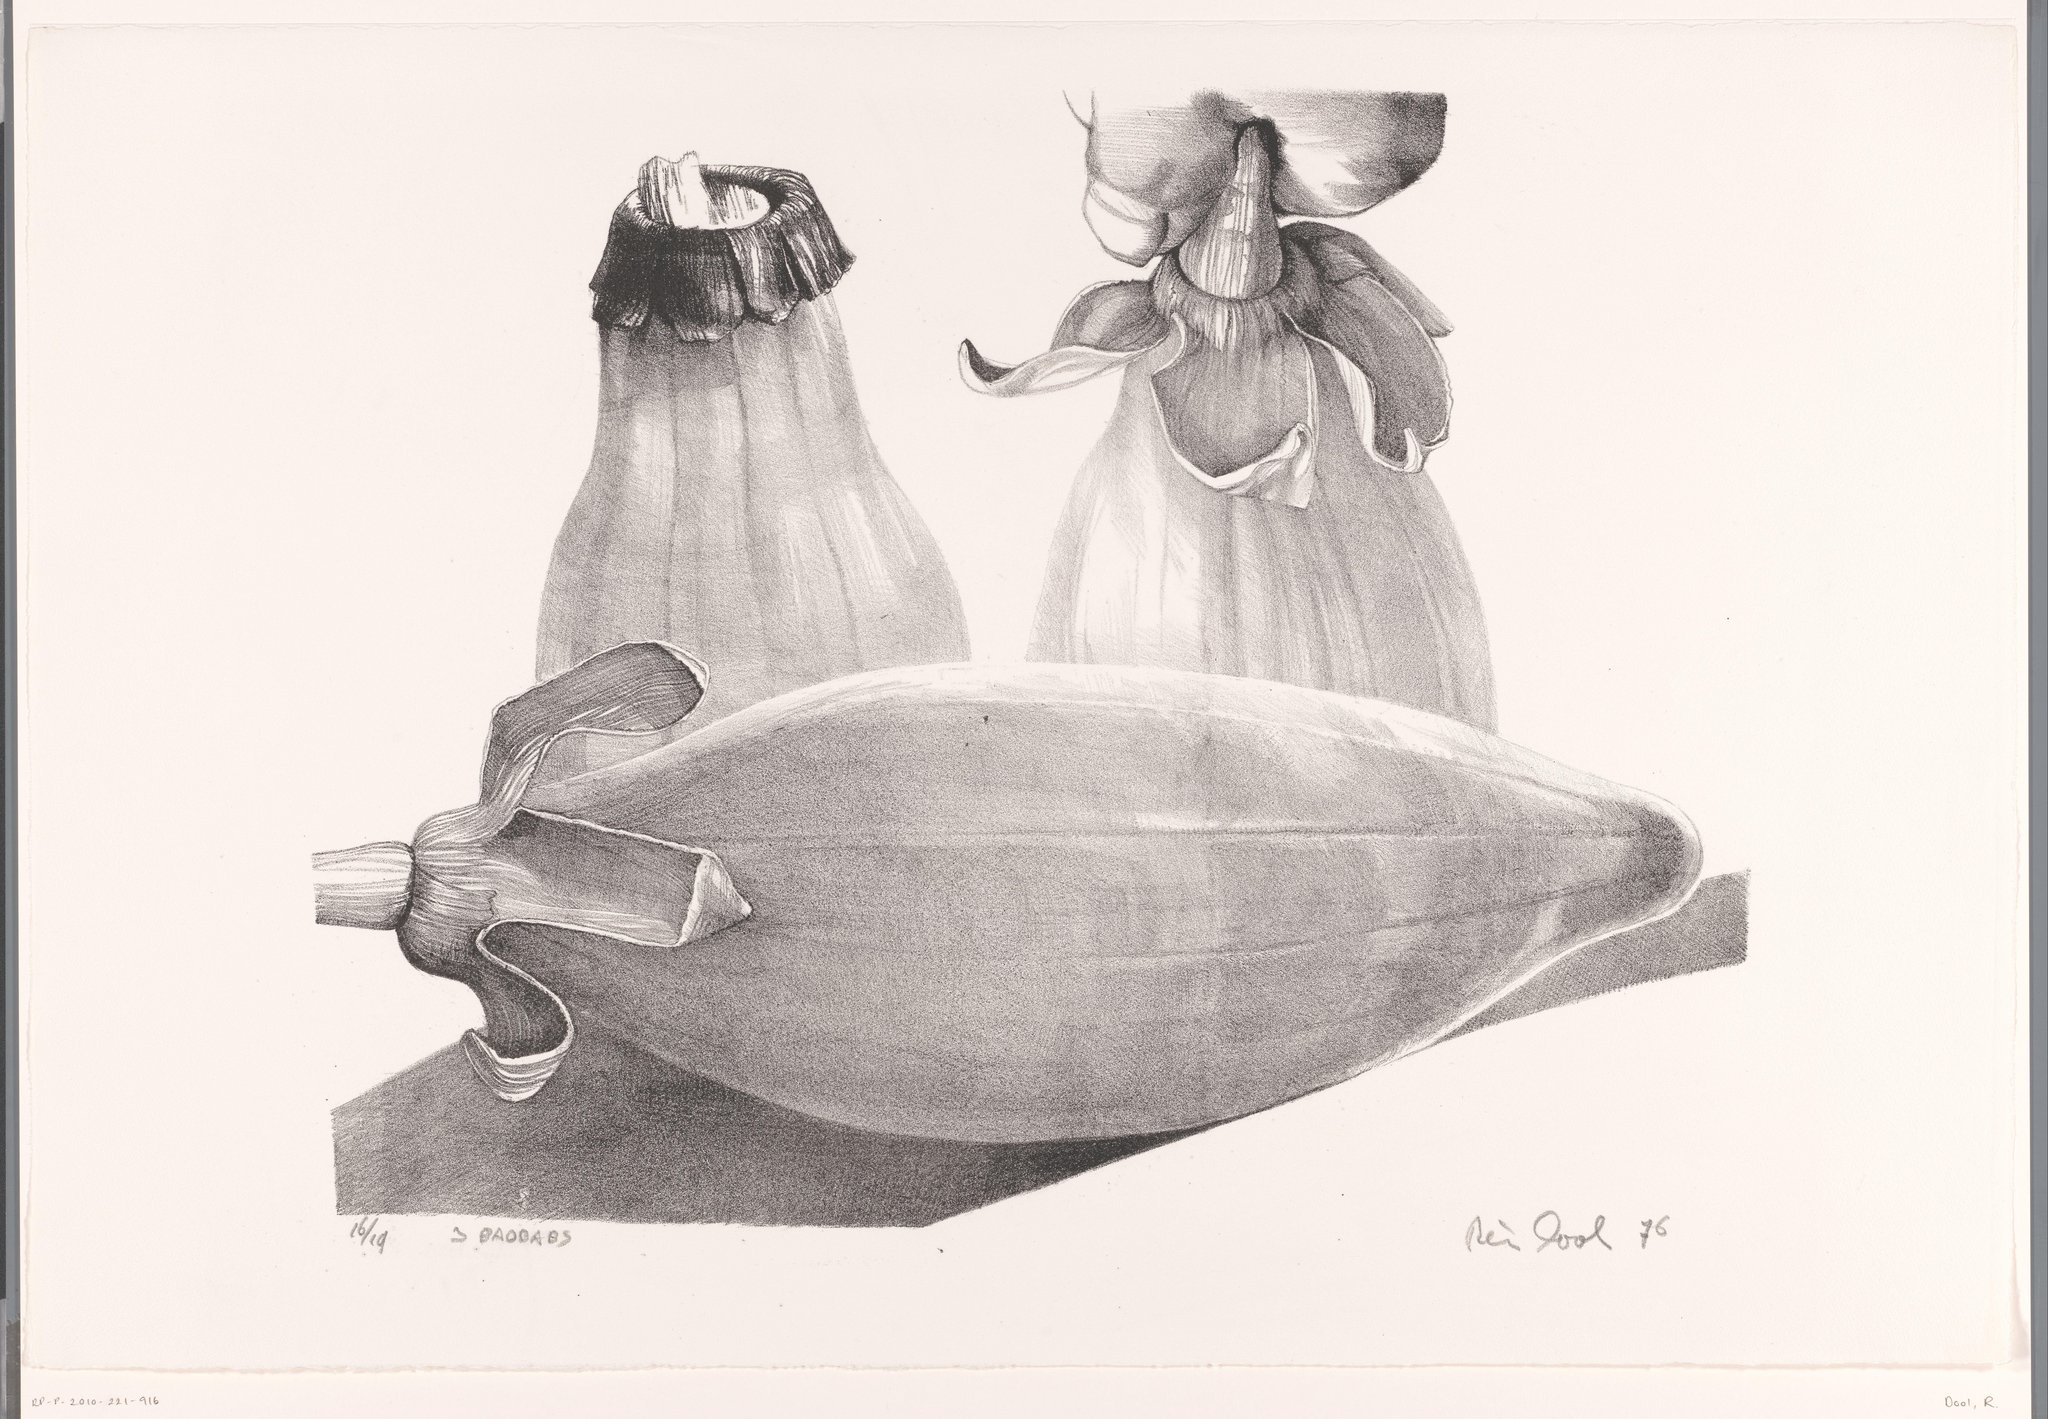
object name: print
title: Drie baobabs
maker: rein dool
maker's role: draughtsman, painter, print maker, sculptor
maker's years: 1933-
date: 1976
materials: paper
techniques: lithograph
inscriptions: edition: ‘16/19’, title: ‘3 BAOBABS’, signature and date: ‘Rein Dool 76’